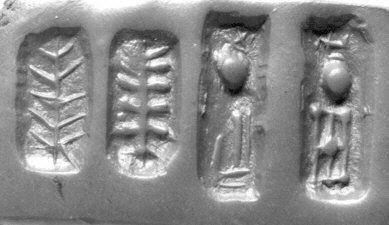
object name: stamp seal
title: Rectangular prism (?) seal engraved on six faces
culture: hittite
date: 1400-1300 BCE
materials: stone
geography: anatolia or syria